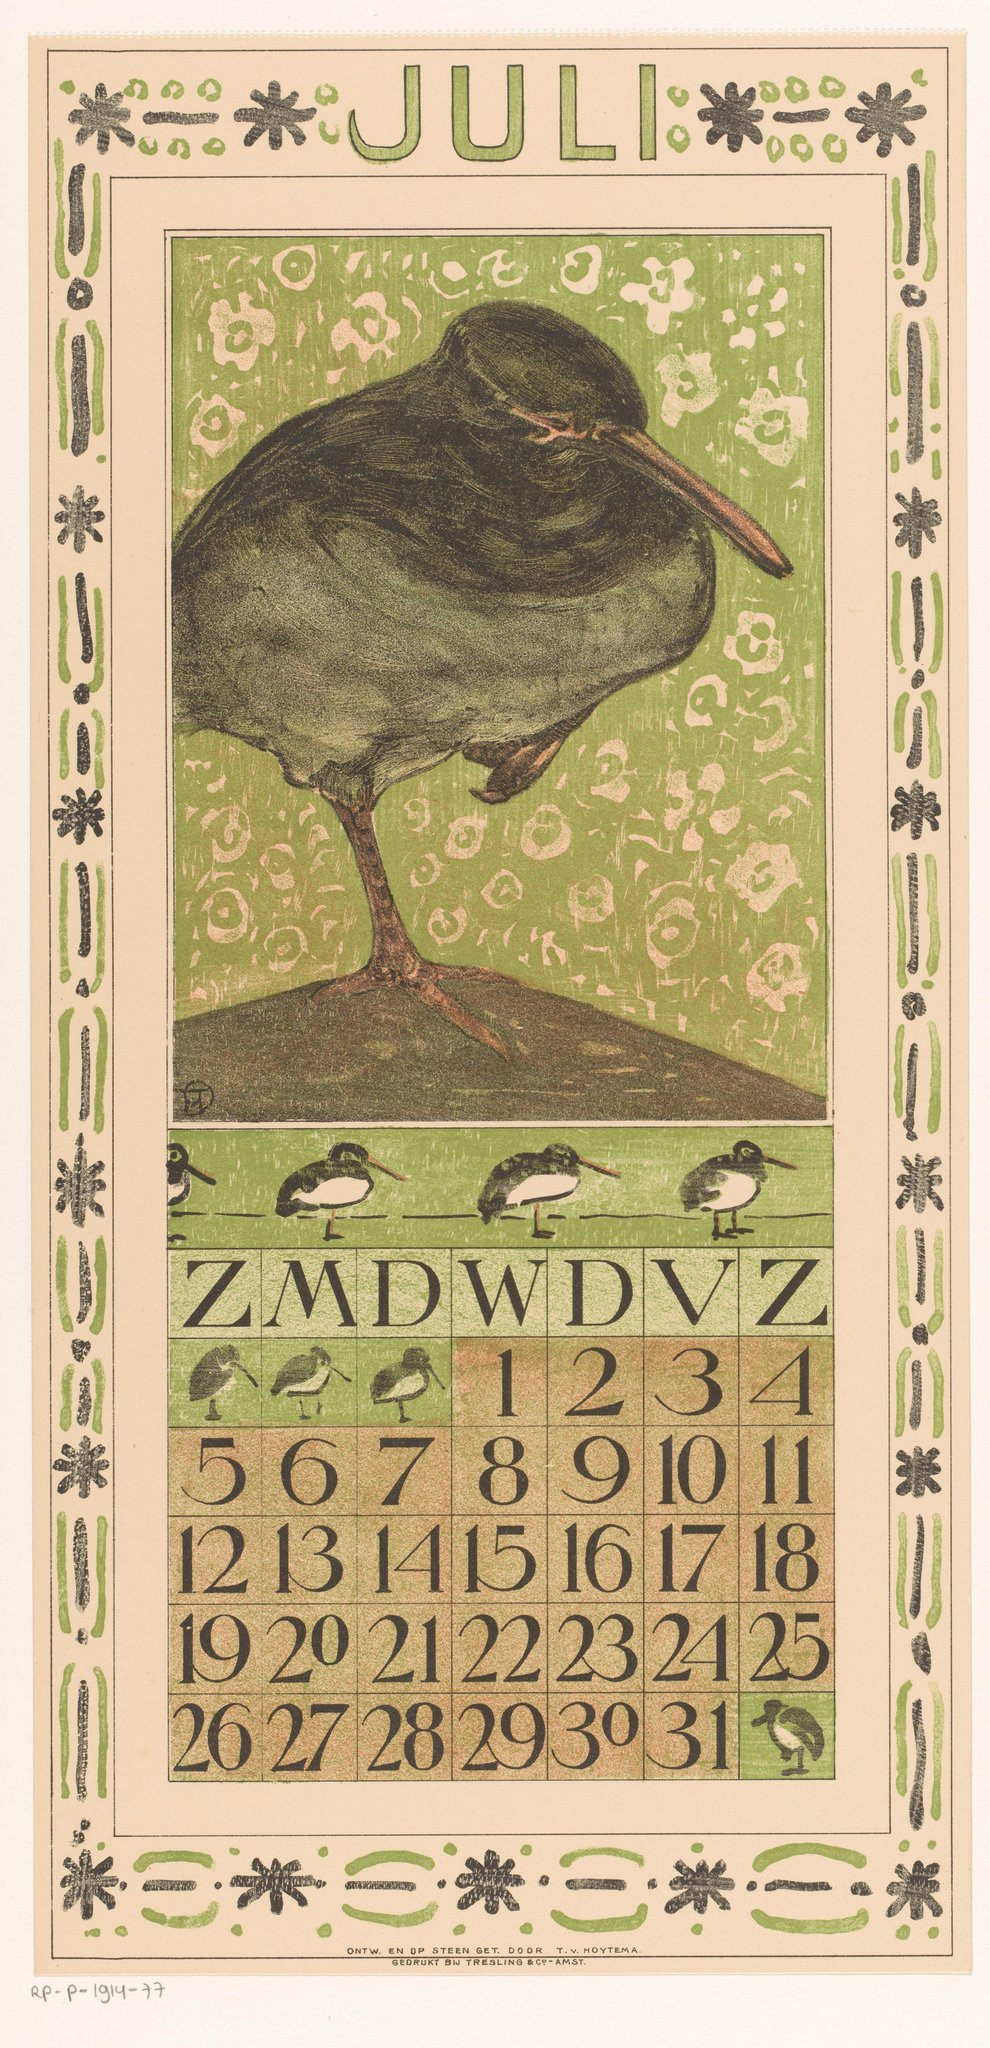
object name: calendar leaf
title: Kalender 1908 12 lithografien door Th. v. Hoytema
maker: theo van hoytema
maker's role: draughtsman, painter, print maker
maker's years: 1863-1917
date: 1907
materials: paper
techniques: lithograph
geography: the hague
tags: july ~ other concepts, song-birds: magpie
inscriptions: collector's mark: Lugt 2228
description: De vogel staat op een poot. Bovenaan het blad een scheurlijn.